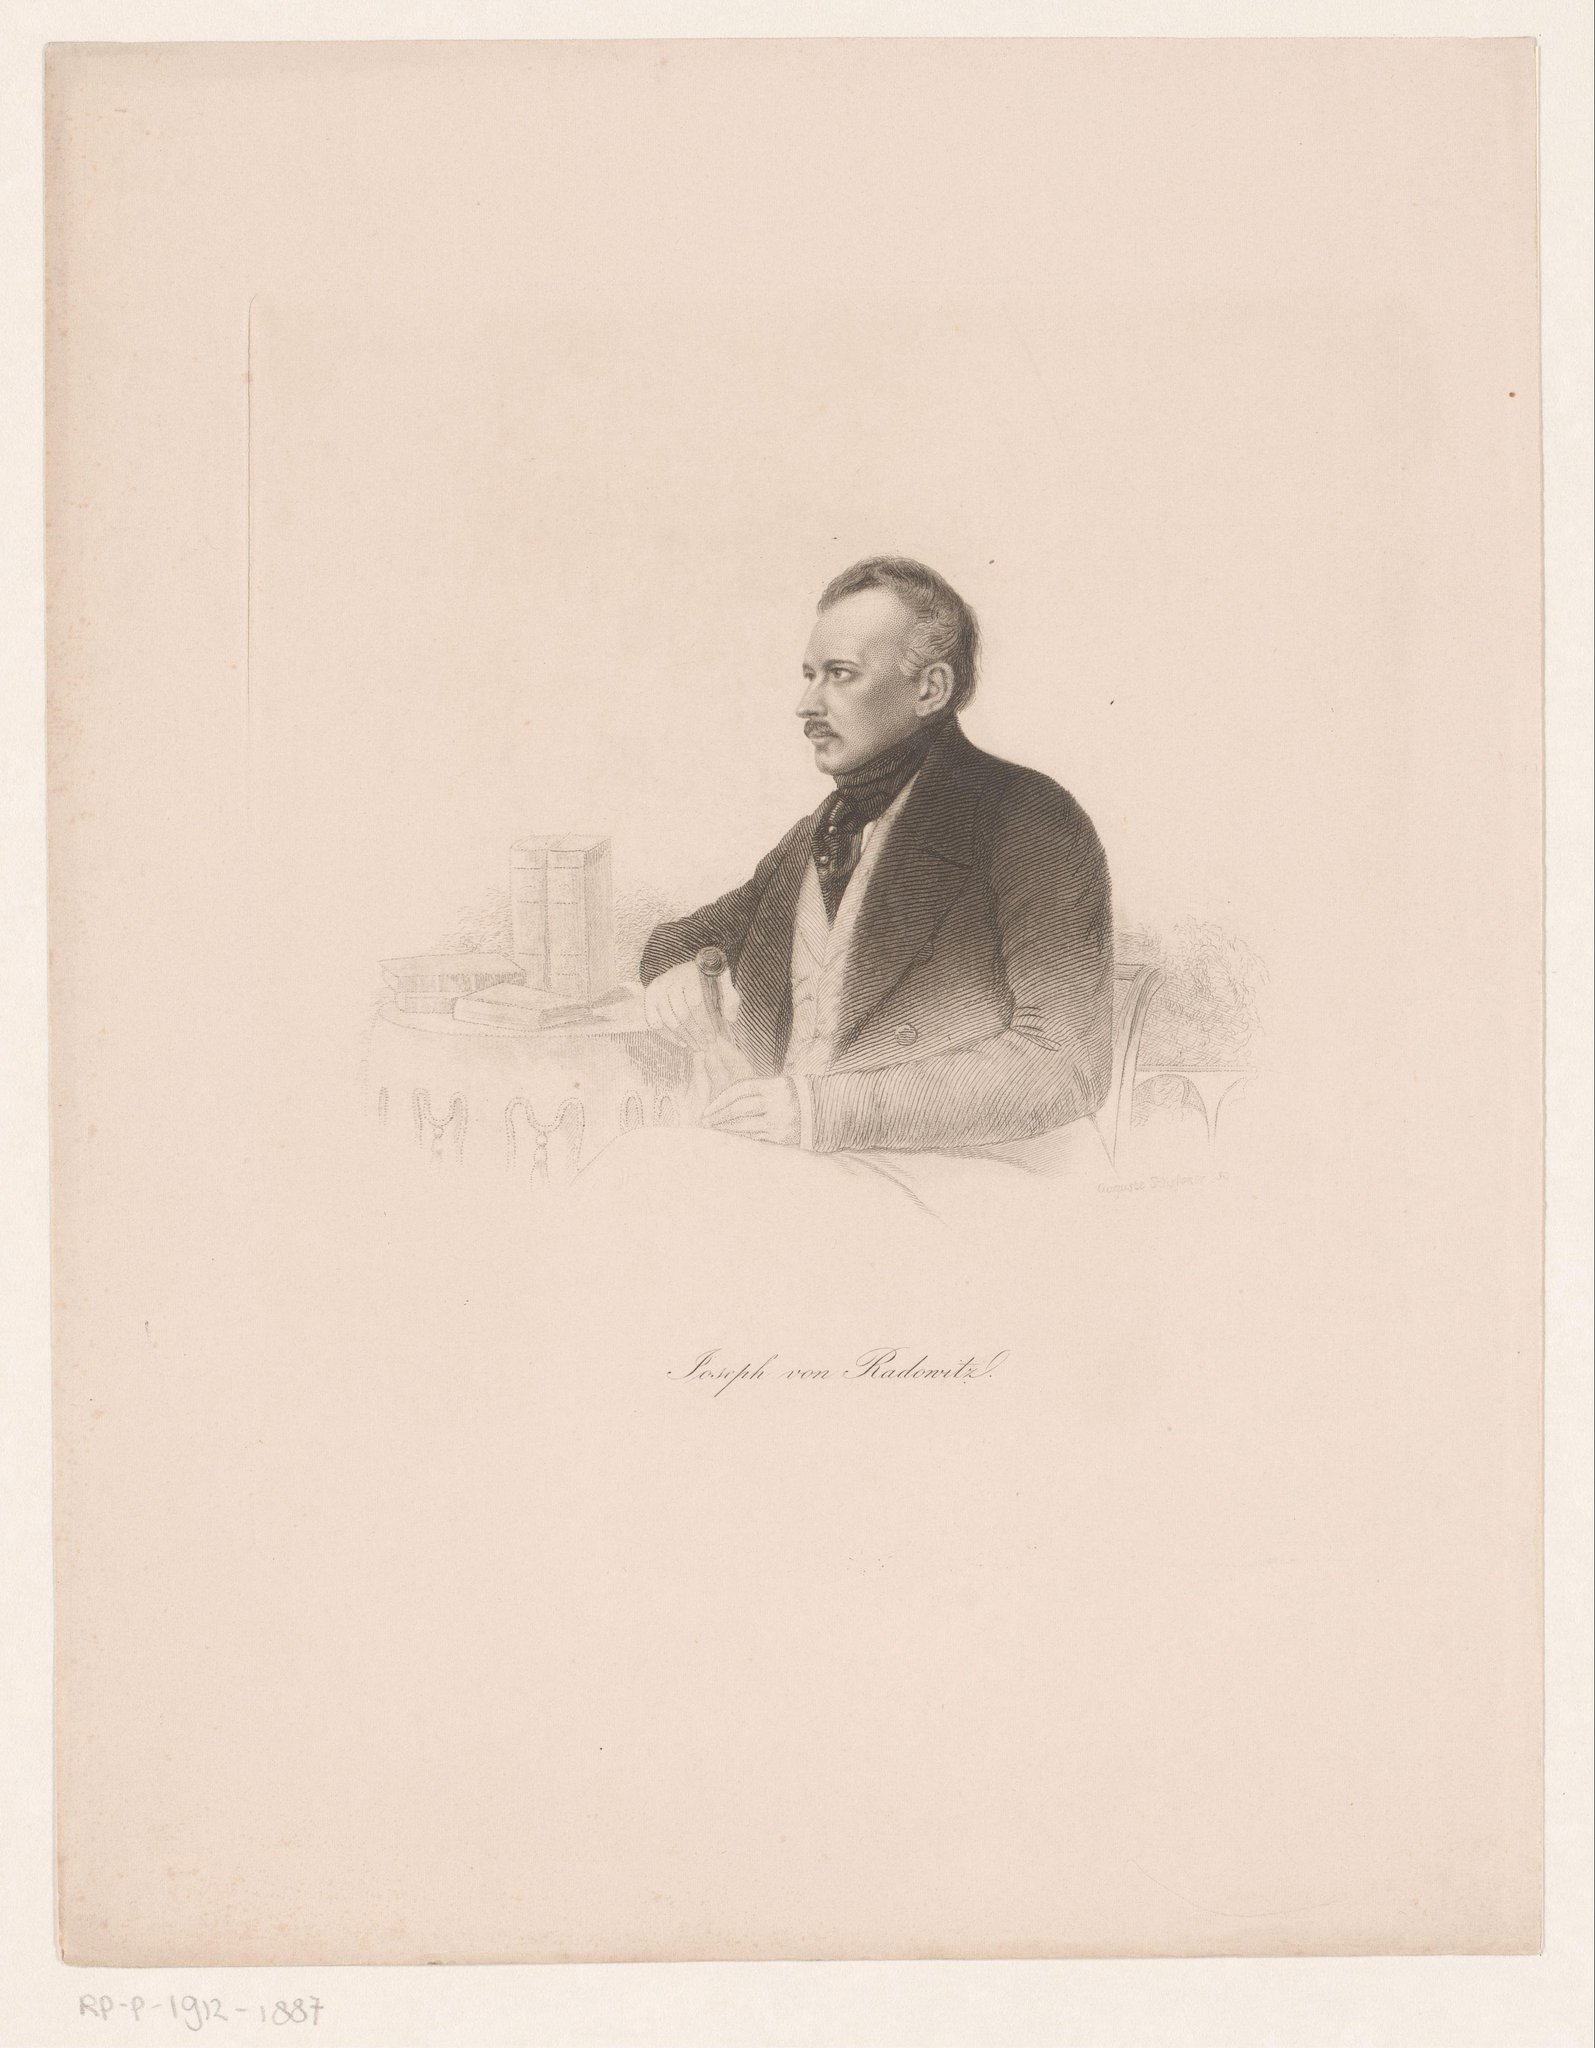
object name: print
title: Portret van Joseph von Radowitz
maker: auguste hüssener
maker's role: print maker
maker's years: 1789-1877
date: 1799-1877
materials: paper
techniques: etching, intaglio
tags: berlin, politician, minister ~ government, historical persons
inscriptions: collector's mark: Lugt 2228